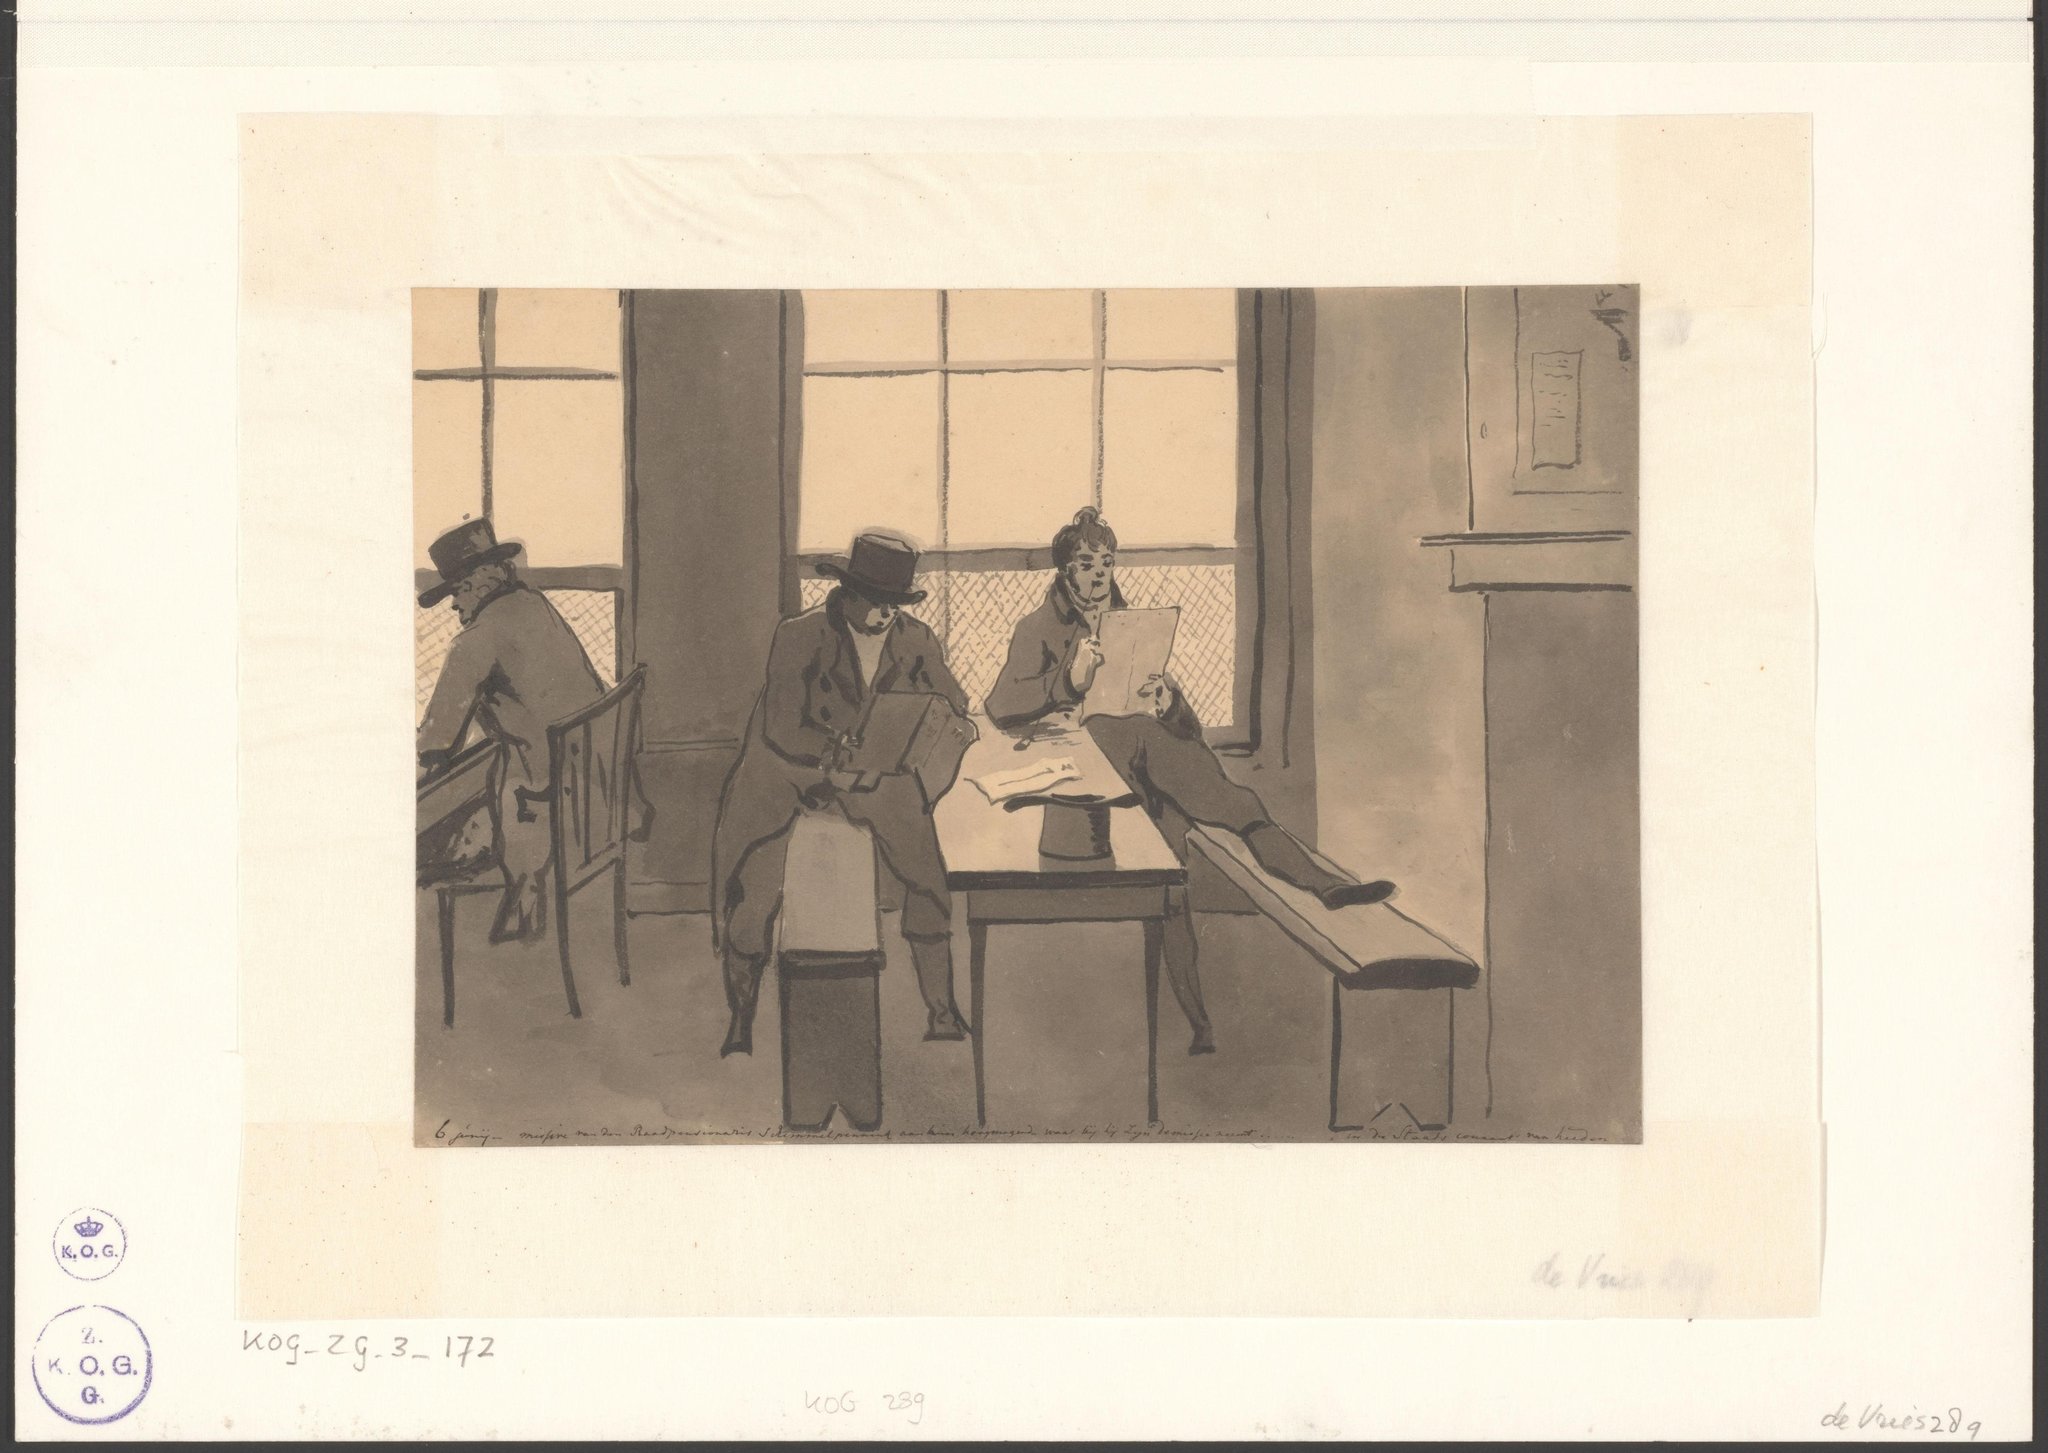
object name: drawing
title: Bericht in de Bataafsche Staats Courant over Rutger Jan Schimmelpenninck wordt gelezen in het koffiehuis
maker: christiaan andriessen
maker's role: draughtsman, print maker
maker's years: 1775-1846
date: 1806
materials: ink, paper, pencil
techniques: brush, pen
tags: amsterdam, print maker, draughtsman, christiaan andriessen, inn, coffee-house, public house, etc., newspaper, news-sheet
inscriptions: collector's mark: Lugt 1641a, signature: ‘J Andriessen’, collector's mark: Lugt 1641, inscription: ‘6 junij 1806 missive van den raadpensionaris Schimmelpenninck aan hun hoogmogende waarbij hij zijn demissie neemt’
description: Dagboekblad uit het getekende dagboek dat Christiaan Andriessen bijhield van 1805 tot en met 1808.